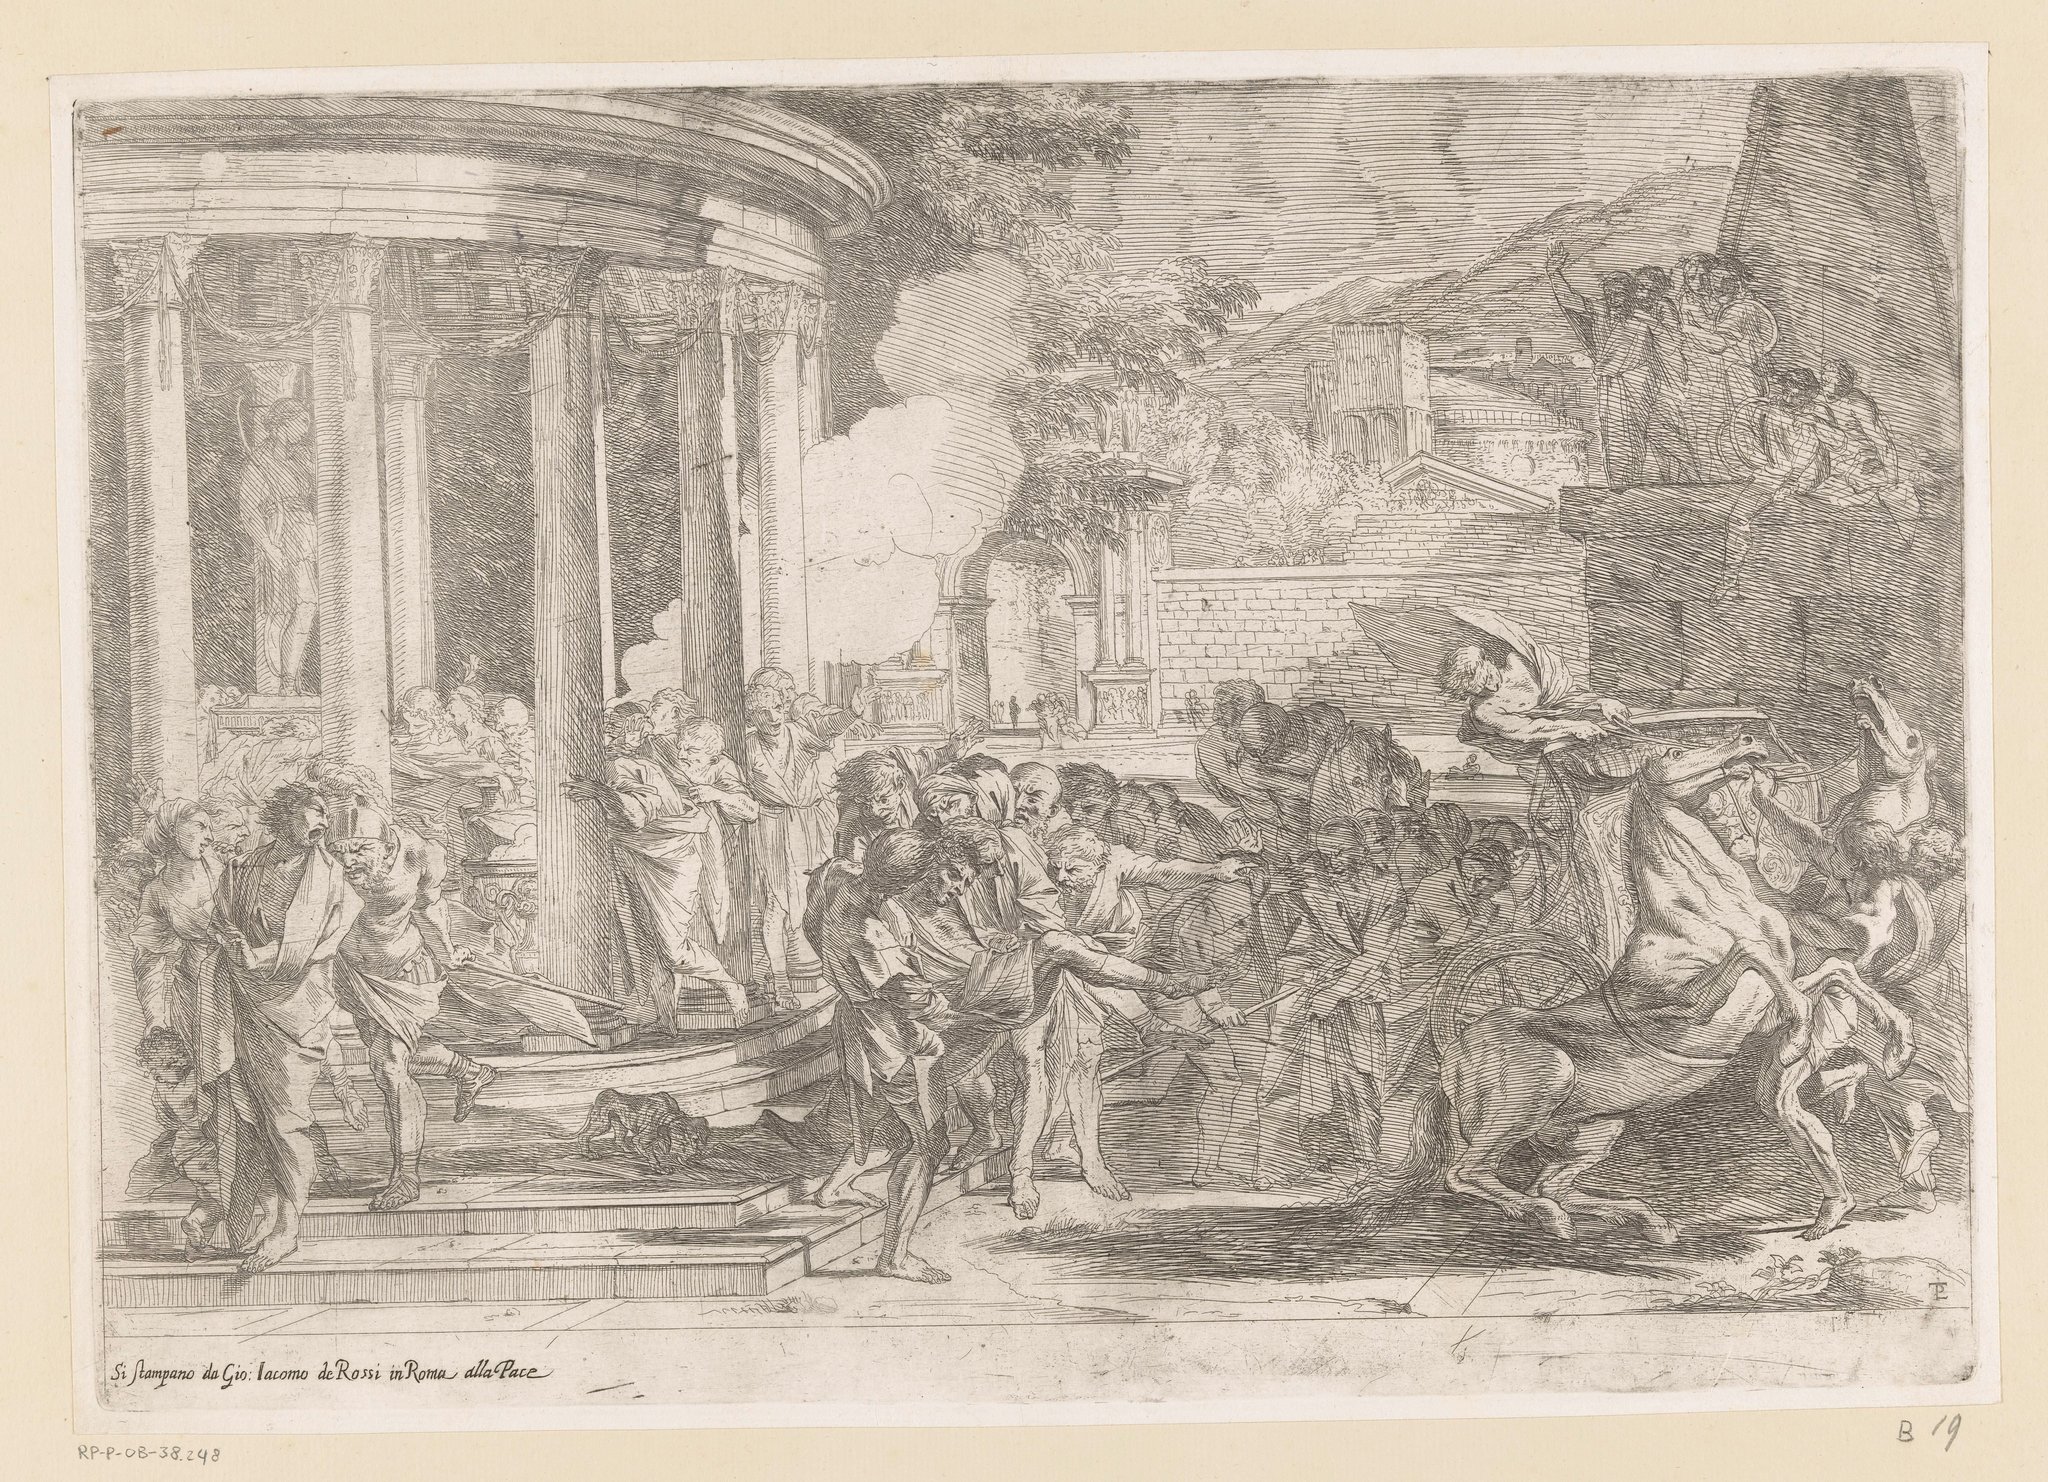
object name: print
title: Sinorix wordt weggedragen na zijn vergiftiging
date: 1640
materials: paper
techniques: etching, intaglio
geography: italy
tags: to avenge the death of her husband upon his murderer sinorix, camma feigns consent to marry him, pours poison into the nuptial bowl and hands it over to sinorix: the dying sinorix is seen struggling out of the temple of diana and trying to reach his carriage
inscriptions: collector's mark: Lugt 240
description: De tetrarch Sinorix is vergiftigd door Camma, een vrouw wiens echtgenoot hij had vermoord. Sinorix wordt gedragen naar zijn wagen die rechts klaarstaat. Links een ronde tempel van Diana. Scène uit Plutarchus' 'De Mulierum Virtutibus'.